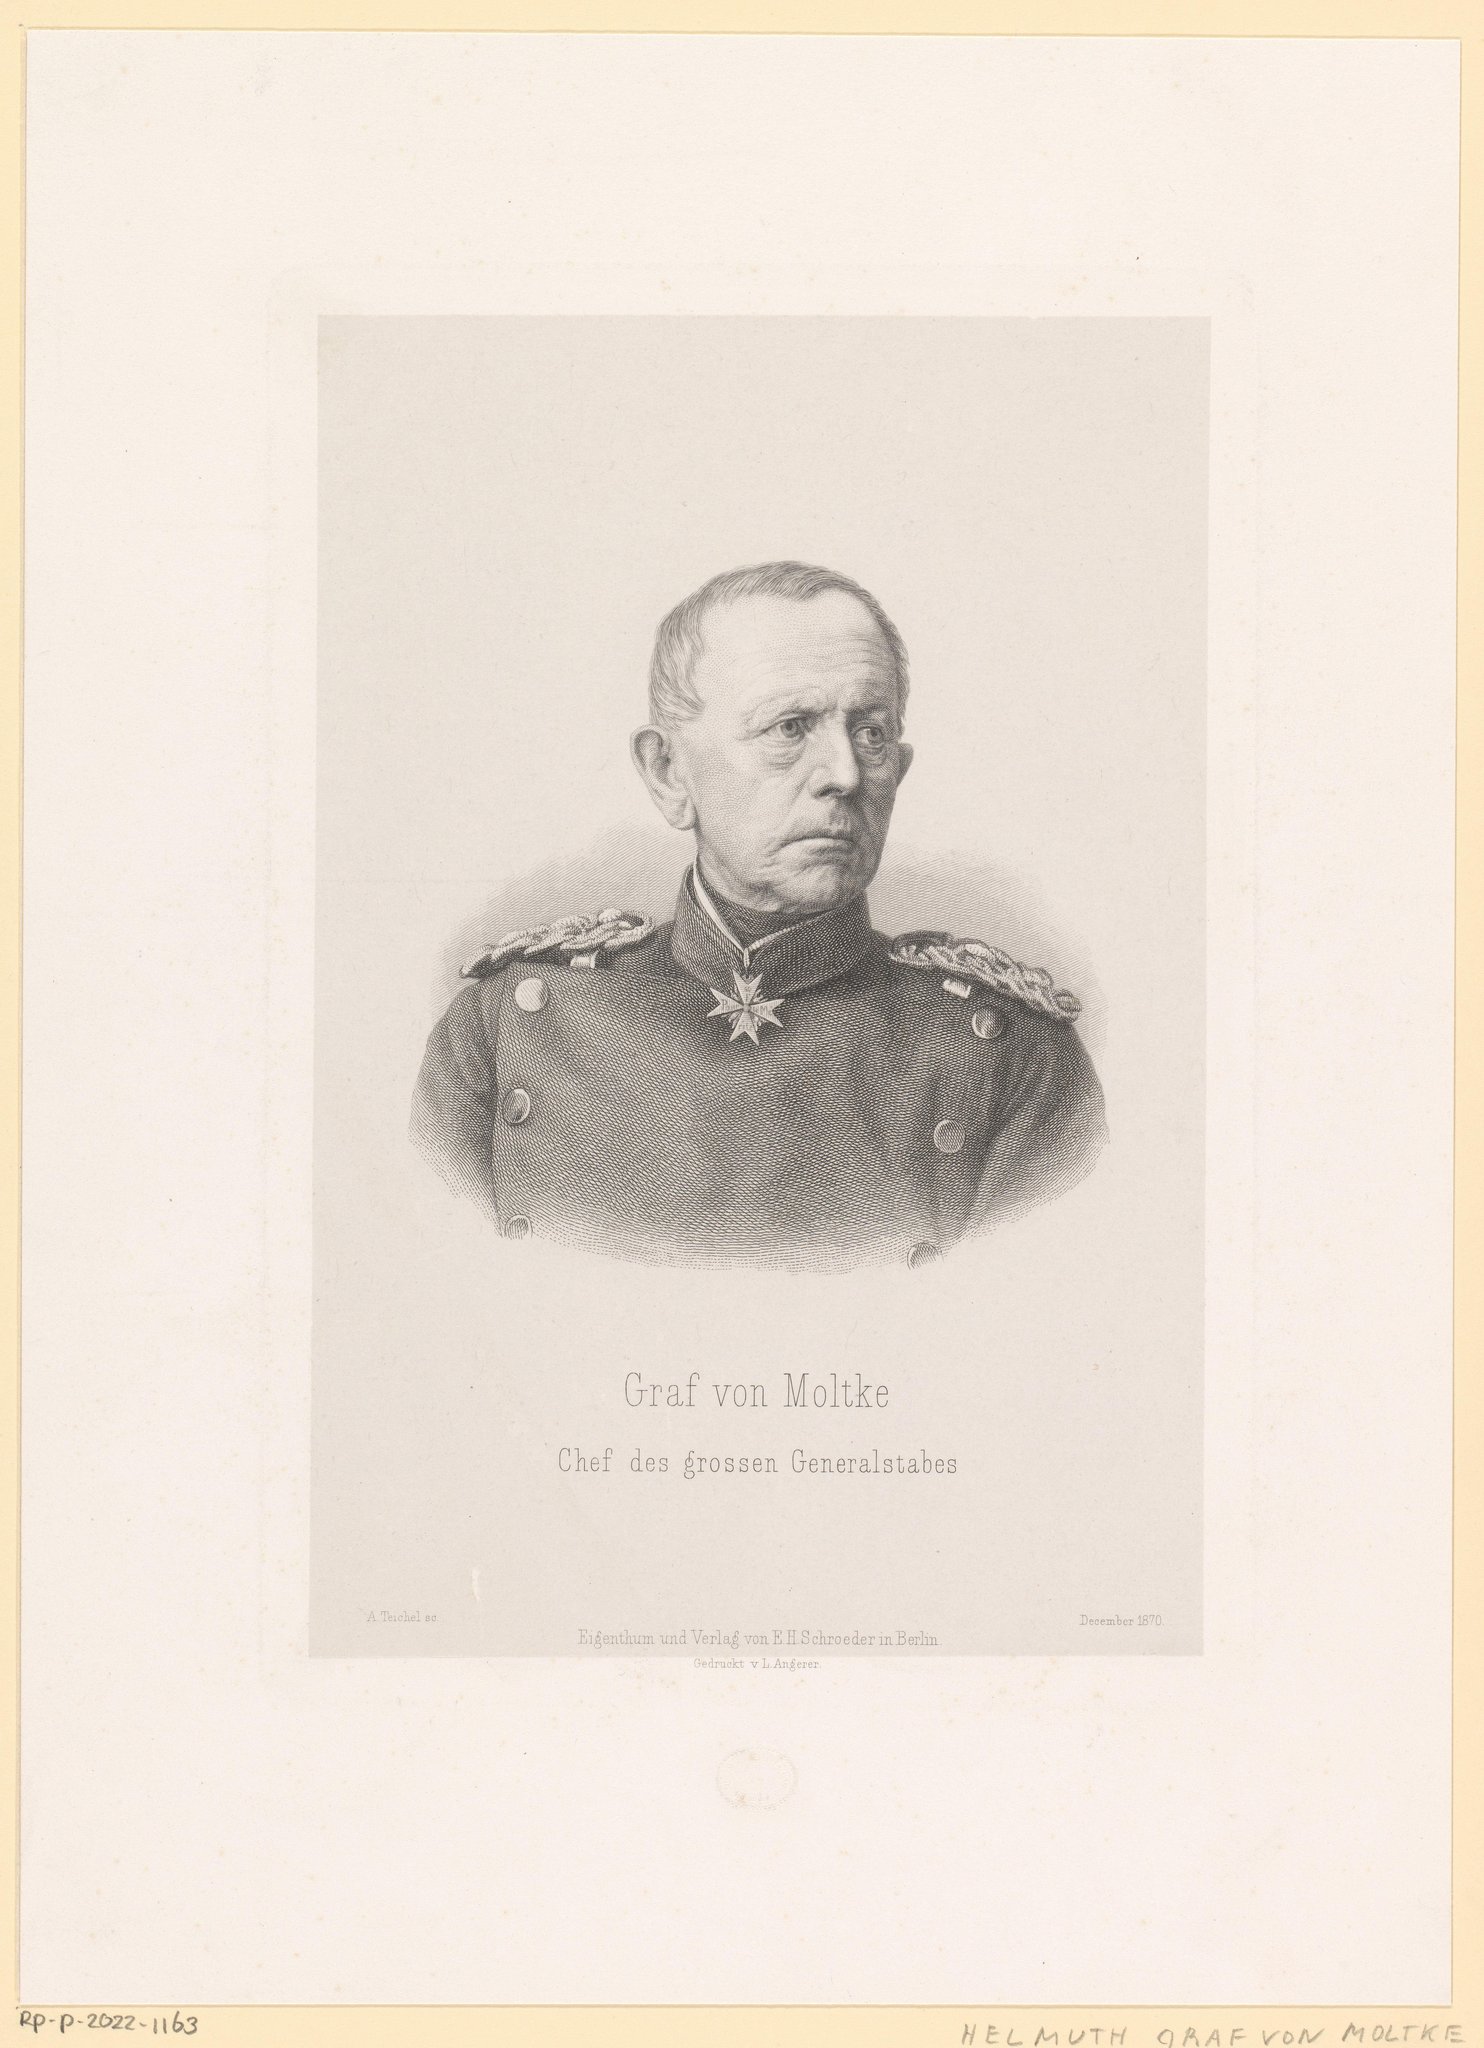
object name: print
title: Portret van Helmuth Karl Bernhard von Moltke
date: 1812-1870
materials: paper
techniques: engraving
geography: berlin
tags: berlin, commander-in-chief, general, marshal, historical persons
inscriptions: collector's mark: Lugt 5326